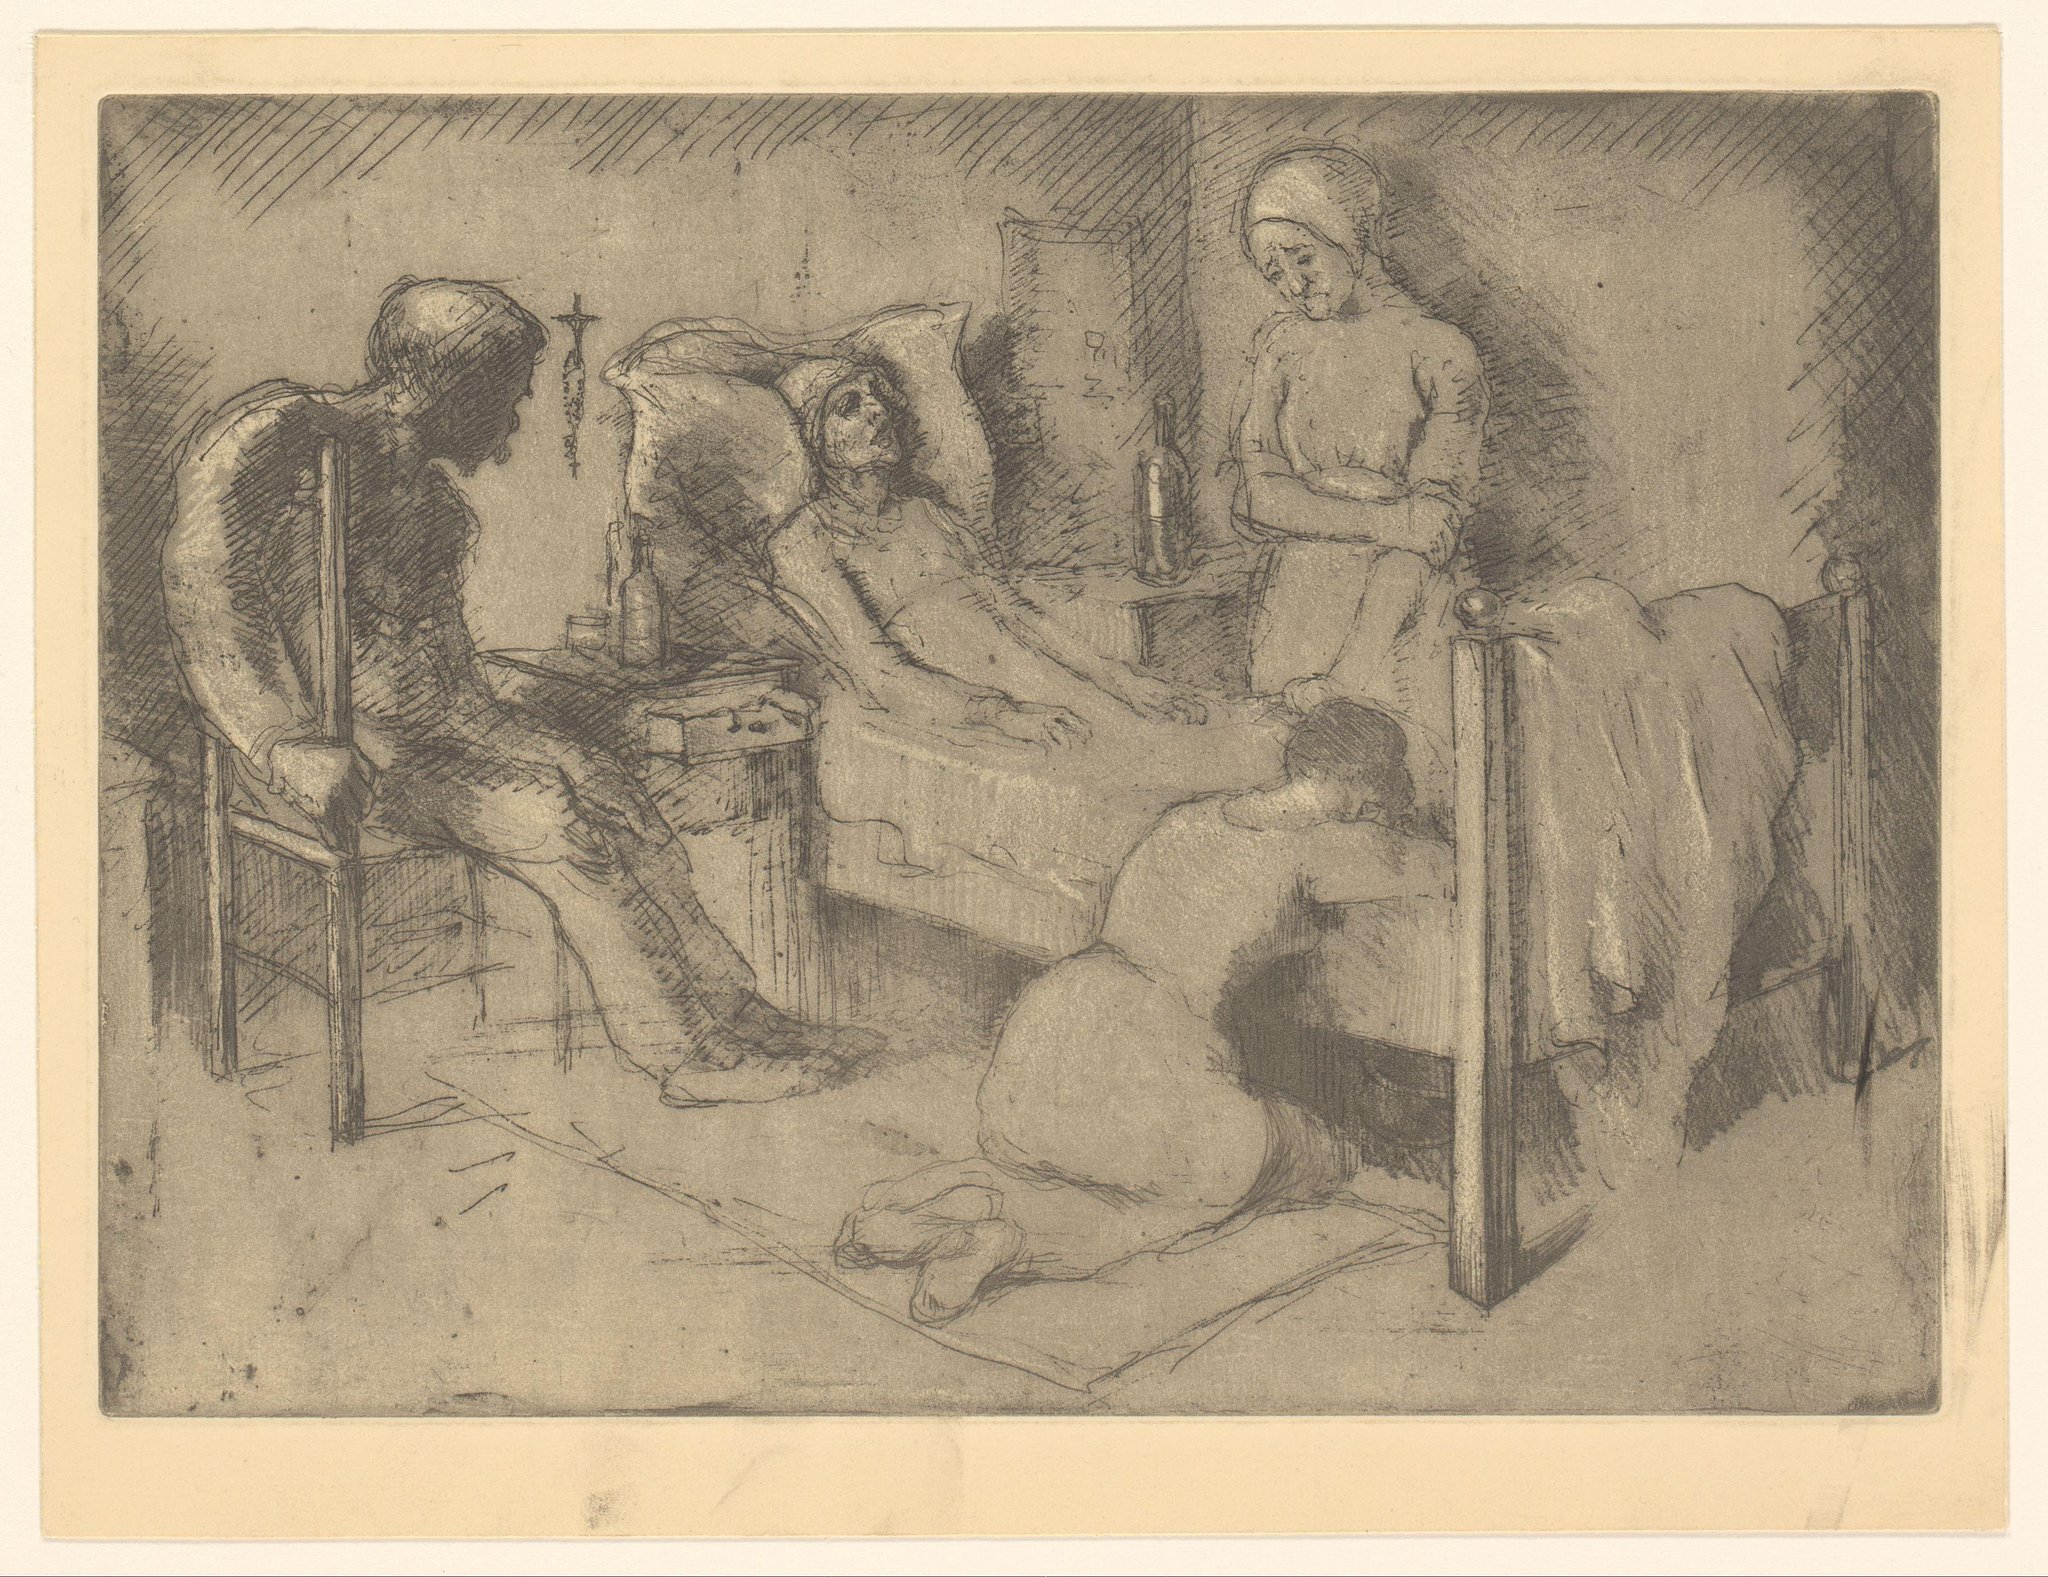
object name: print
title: Familie rondom een doodsbed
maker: armand rassenfosse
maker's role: draughtsman, painter, print maker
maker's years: 1862-1934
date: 1915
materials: paper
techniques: etching, soft ground etching, sugar lift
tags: deathbed, family, descendance, mourning the dead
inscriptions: collector's mark: Lugt 2228